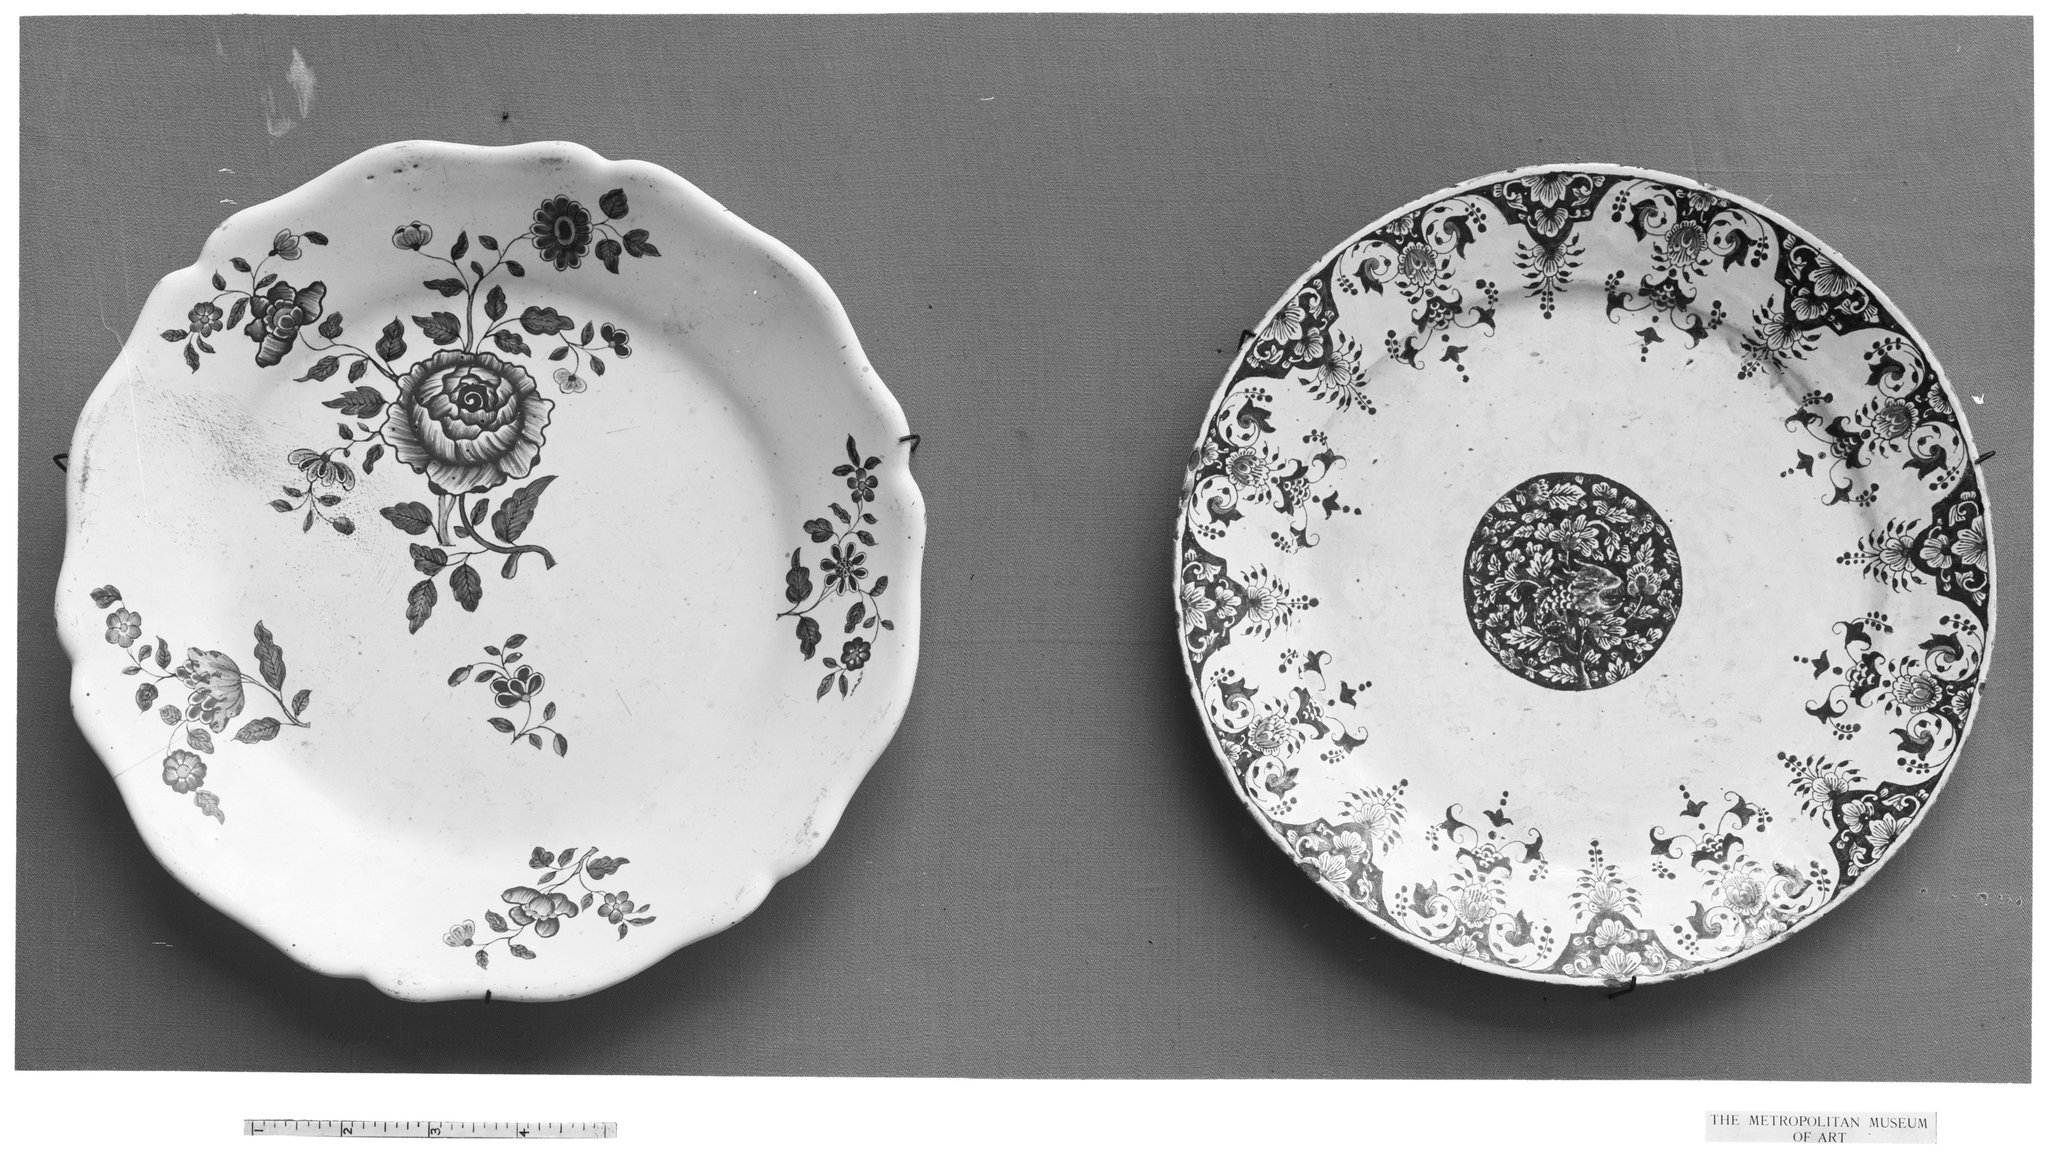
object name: plate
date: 1701-1800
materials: faience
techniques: glazing